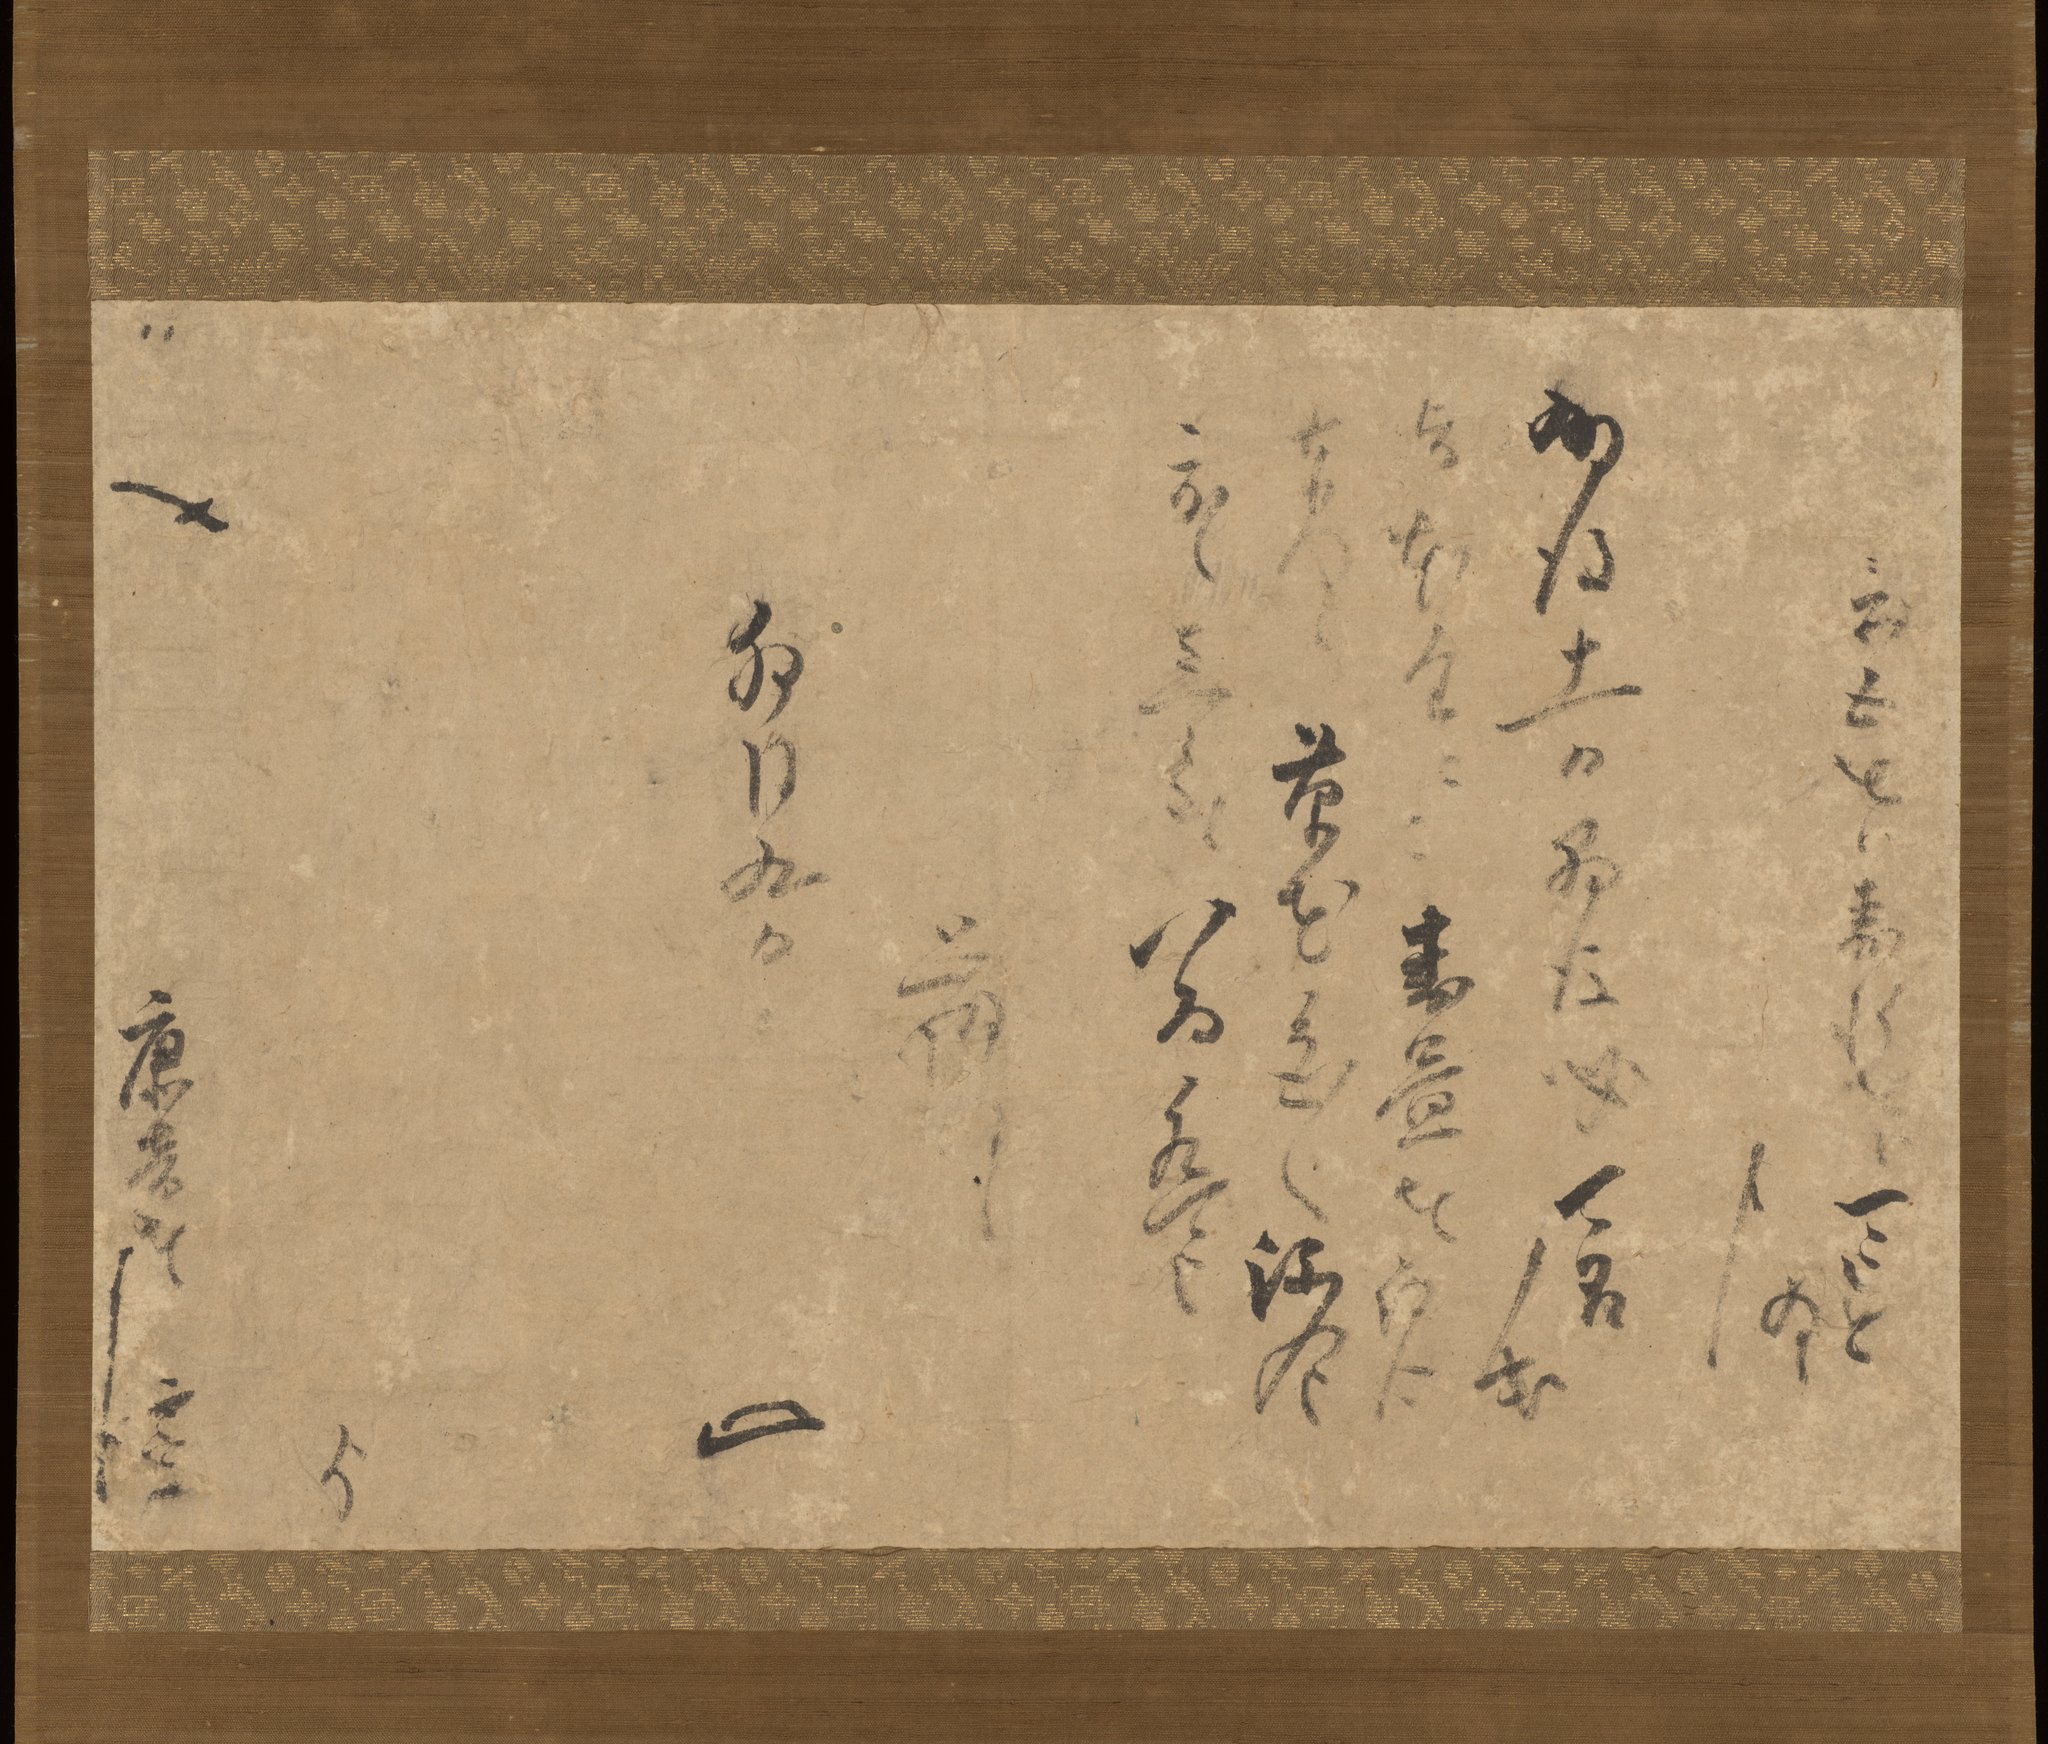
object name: letter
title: Letter of Acceptance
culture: japanese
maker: sen sōtan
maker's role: artist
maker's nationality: japanese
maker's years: 1578-1658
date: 1601-1650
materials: ink, paper